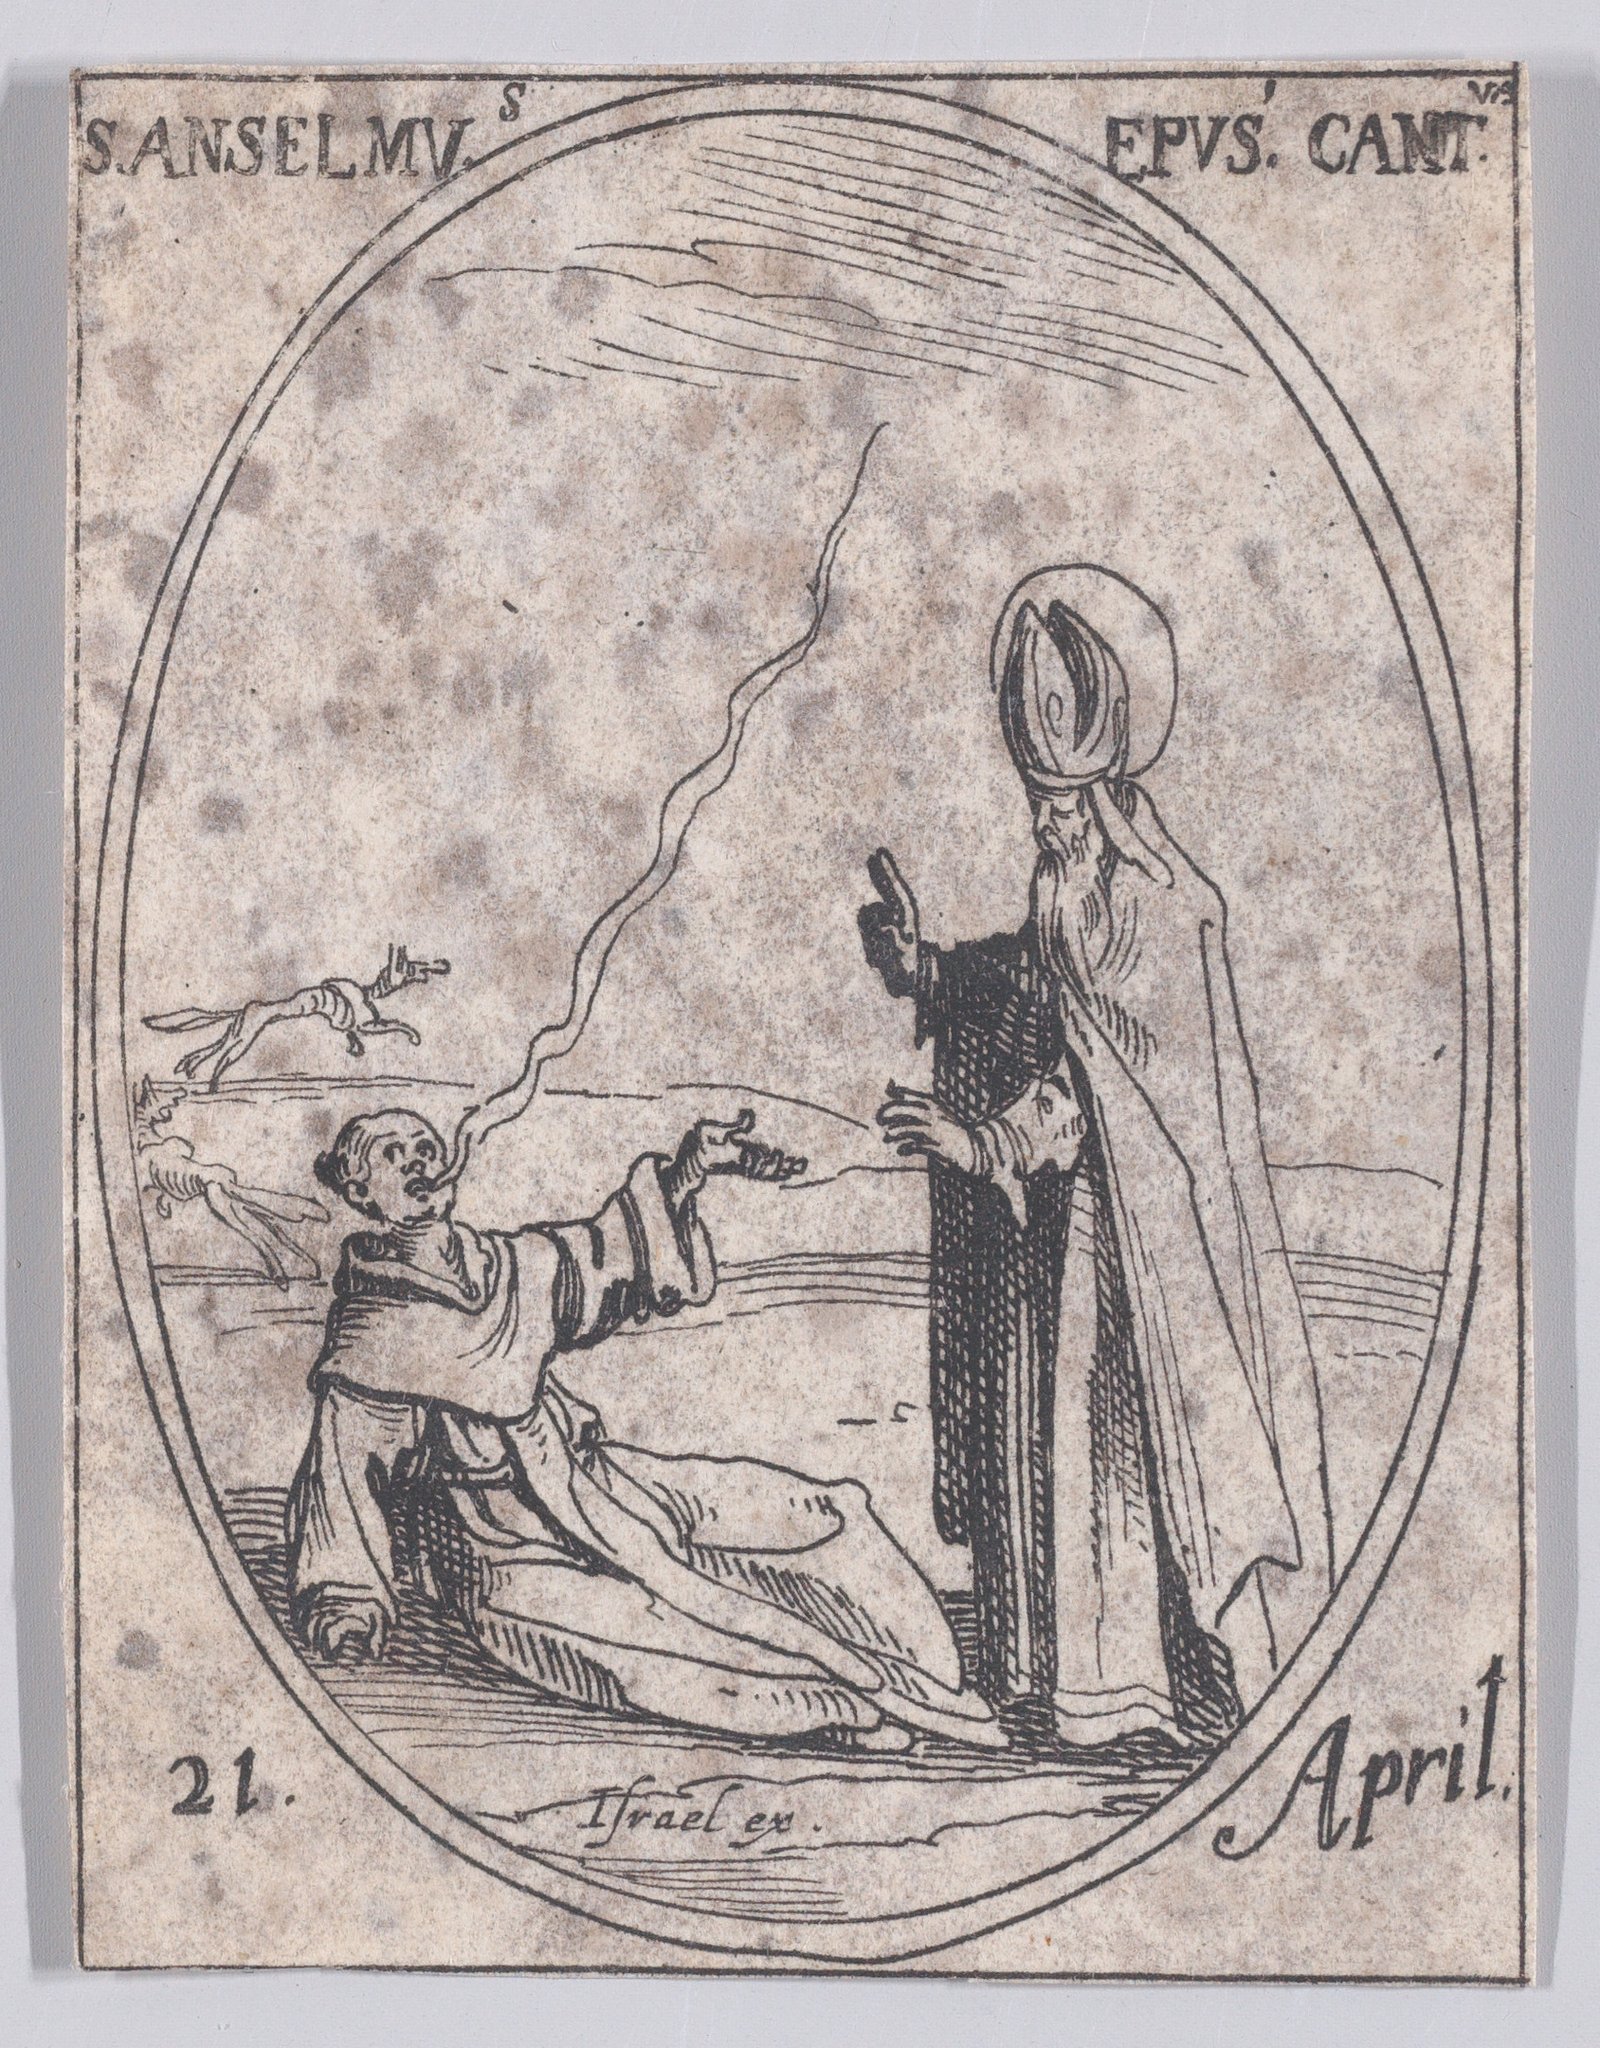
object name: print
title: S. Anselme, évêque de Cantorbéry (St. Anslem, Bishop of Canterbury), April 21st, from "Les Images De Tous Les Saincts et Saintes de L'Année" (Images of All of the Saints and Religious Events of the Year)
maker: jacques callot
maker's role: artist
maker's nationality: french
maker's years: 1592-1635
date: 1636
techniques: etching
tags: men,saints